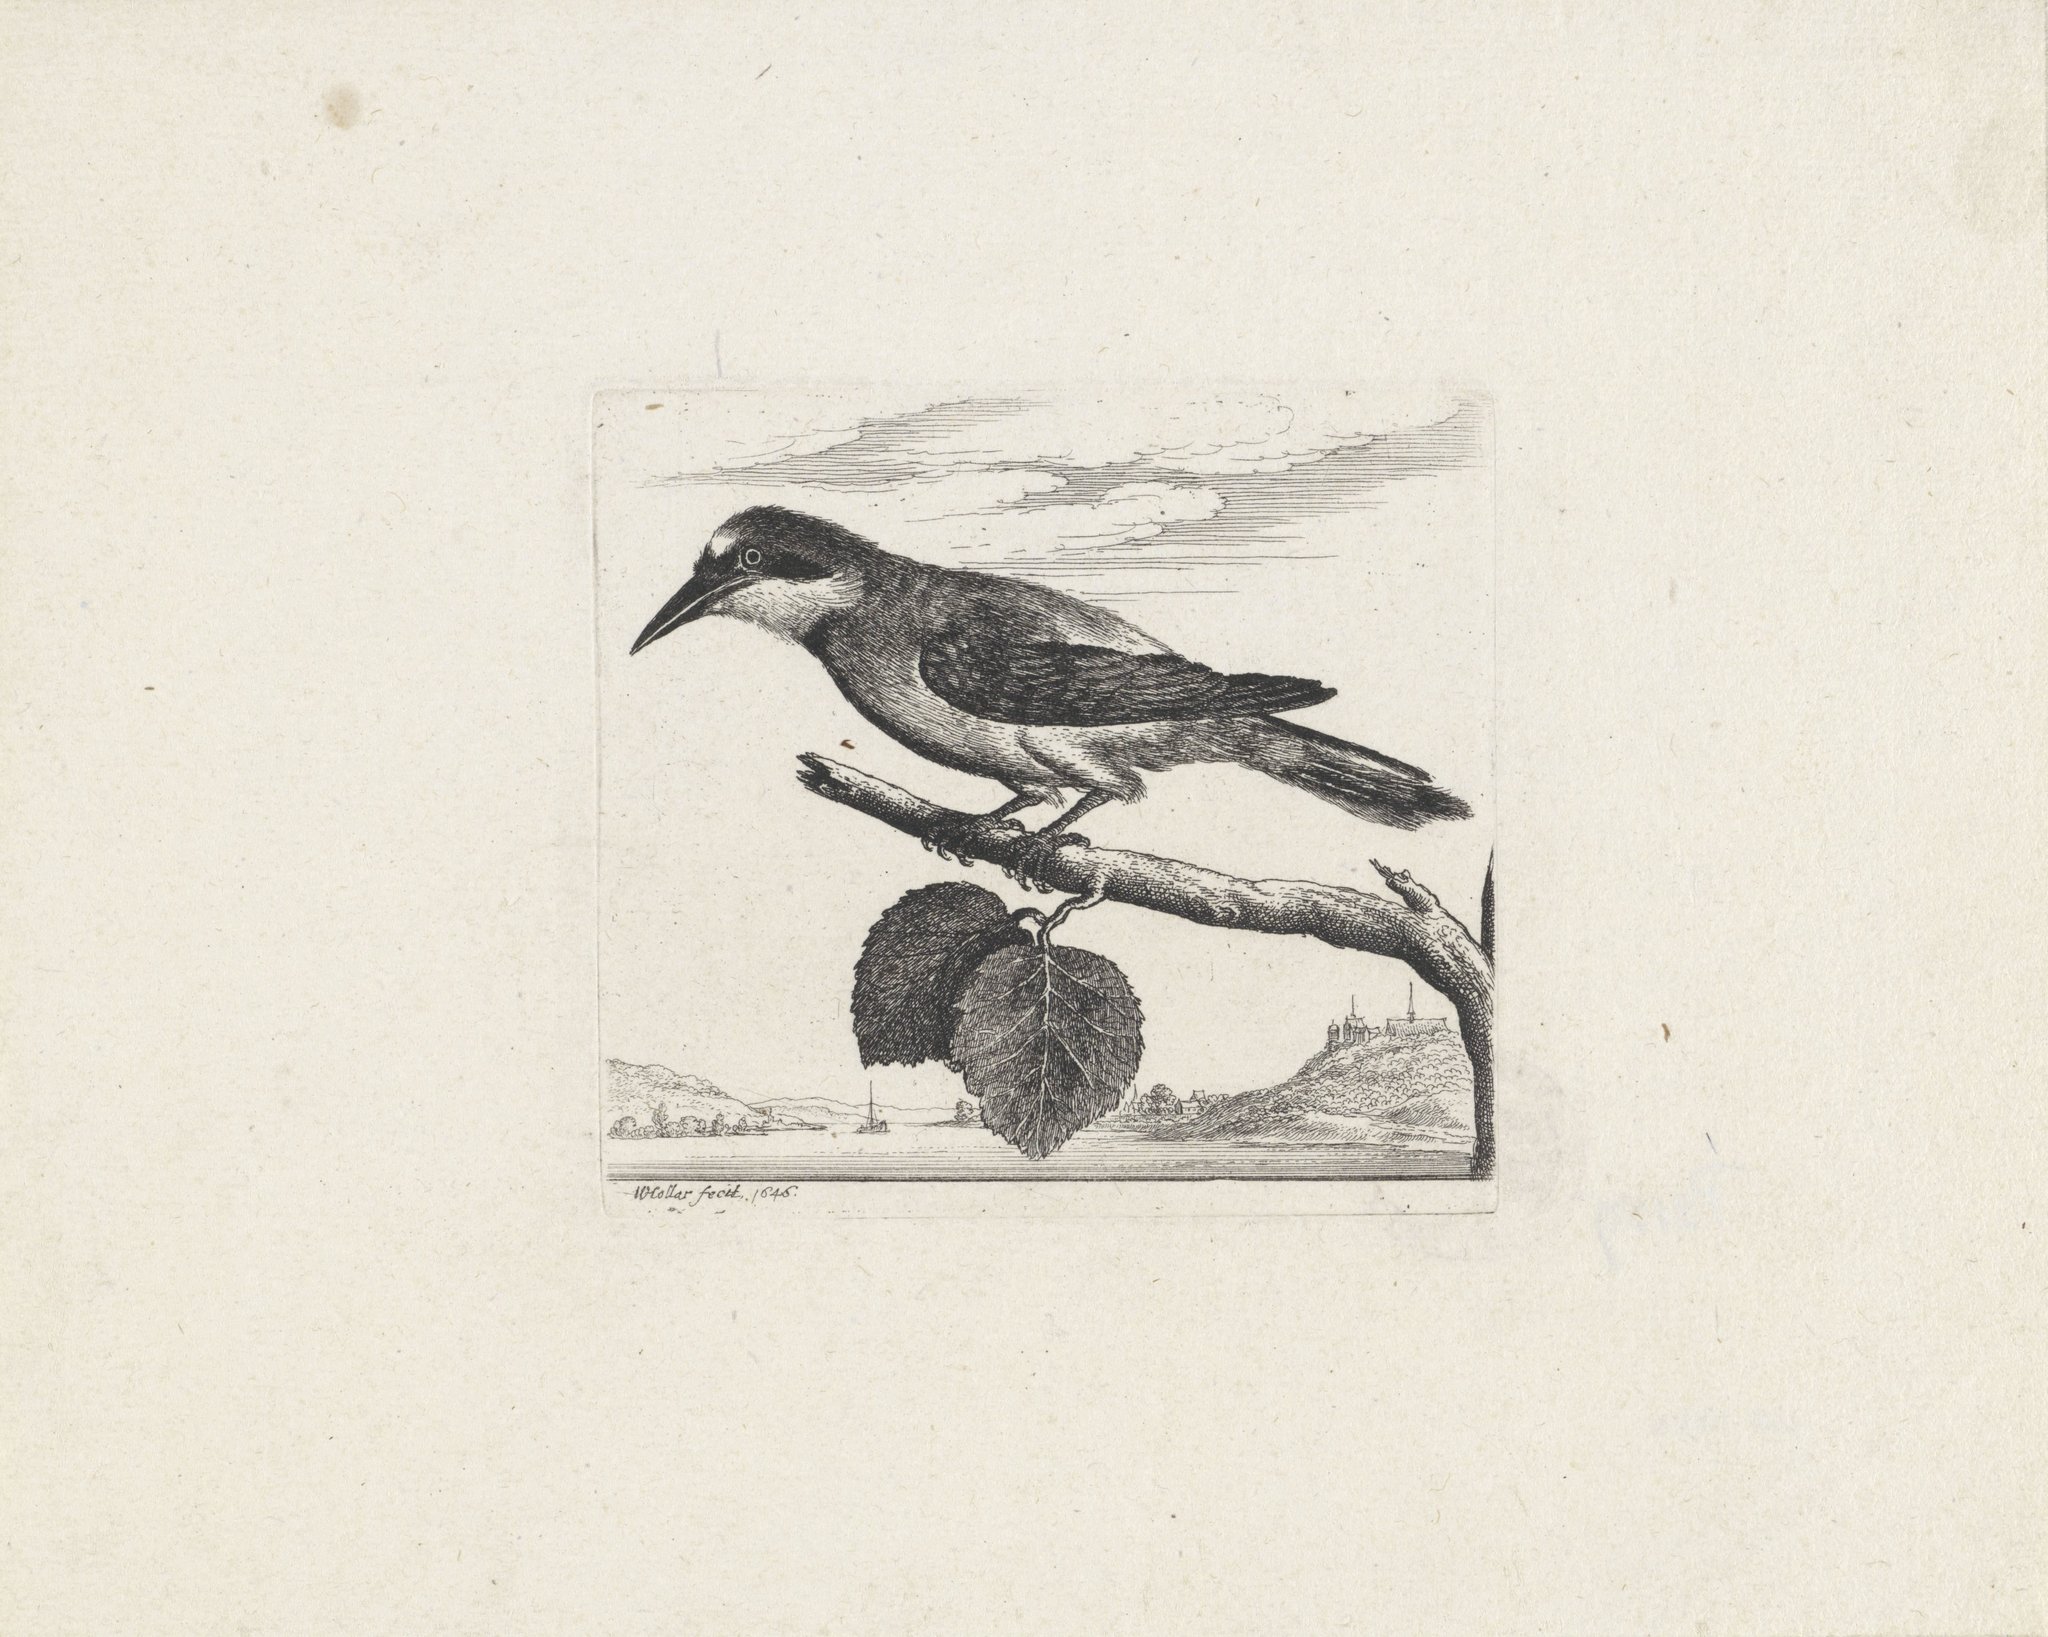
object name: print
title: Vlaamse gaai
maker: wenceslaus hollar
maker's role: draughtsman, print maker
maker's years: 1607-1677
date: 1646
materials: paper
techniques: etching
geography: antwerp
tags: birds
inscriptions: collector's mark: Lugt 240